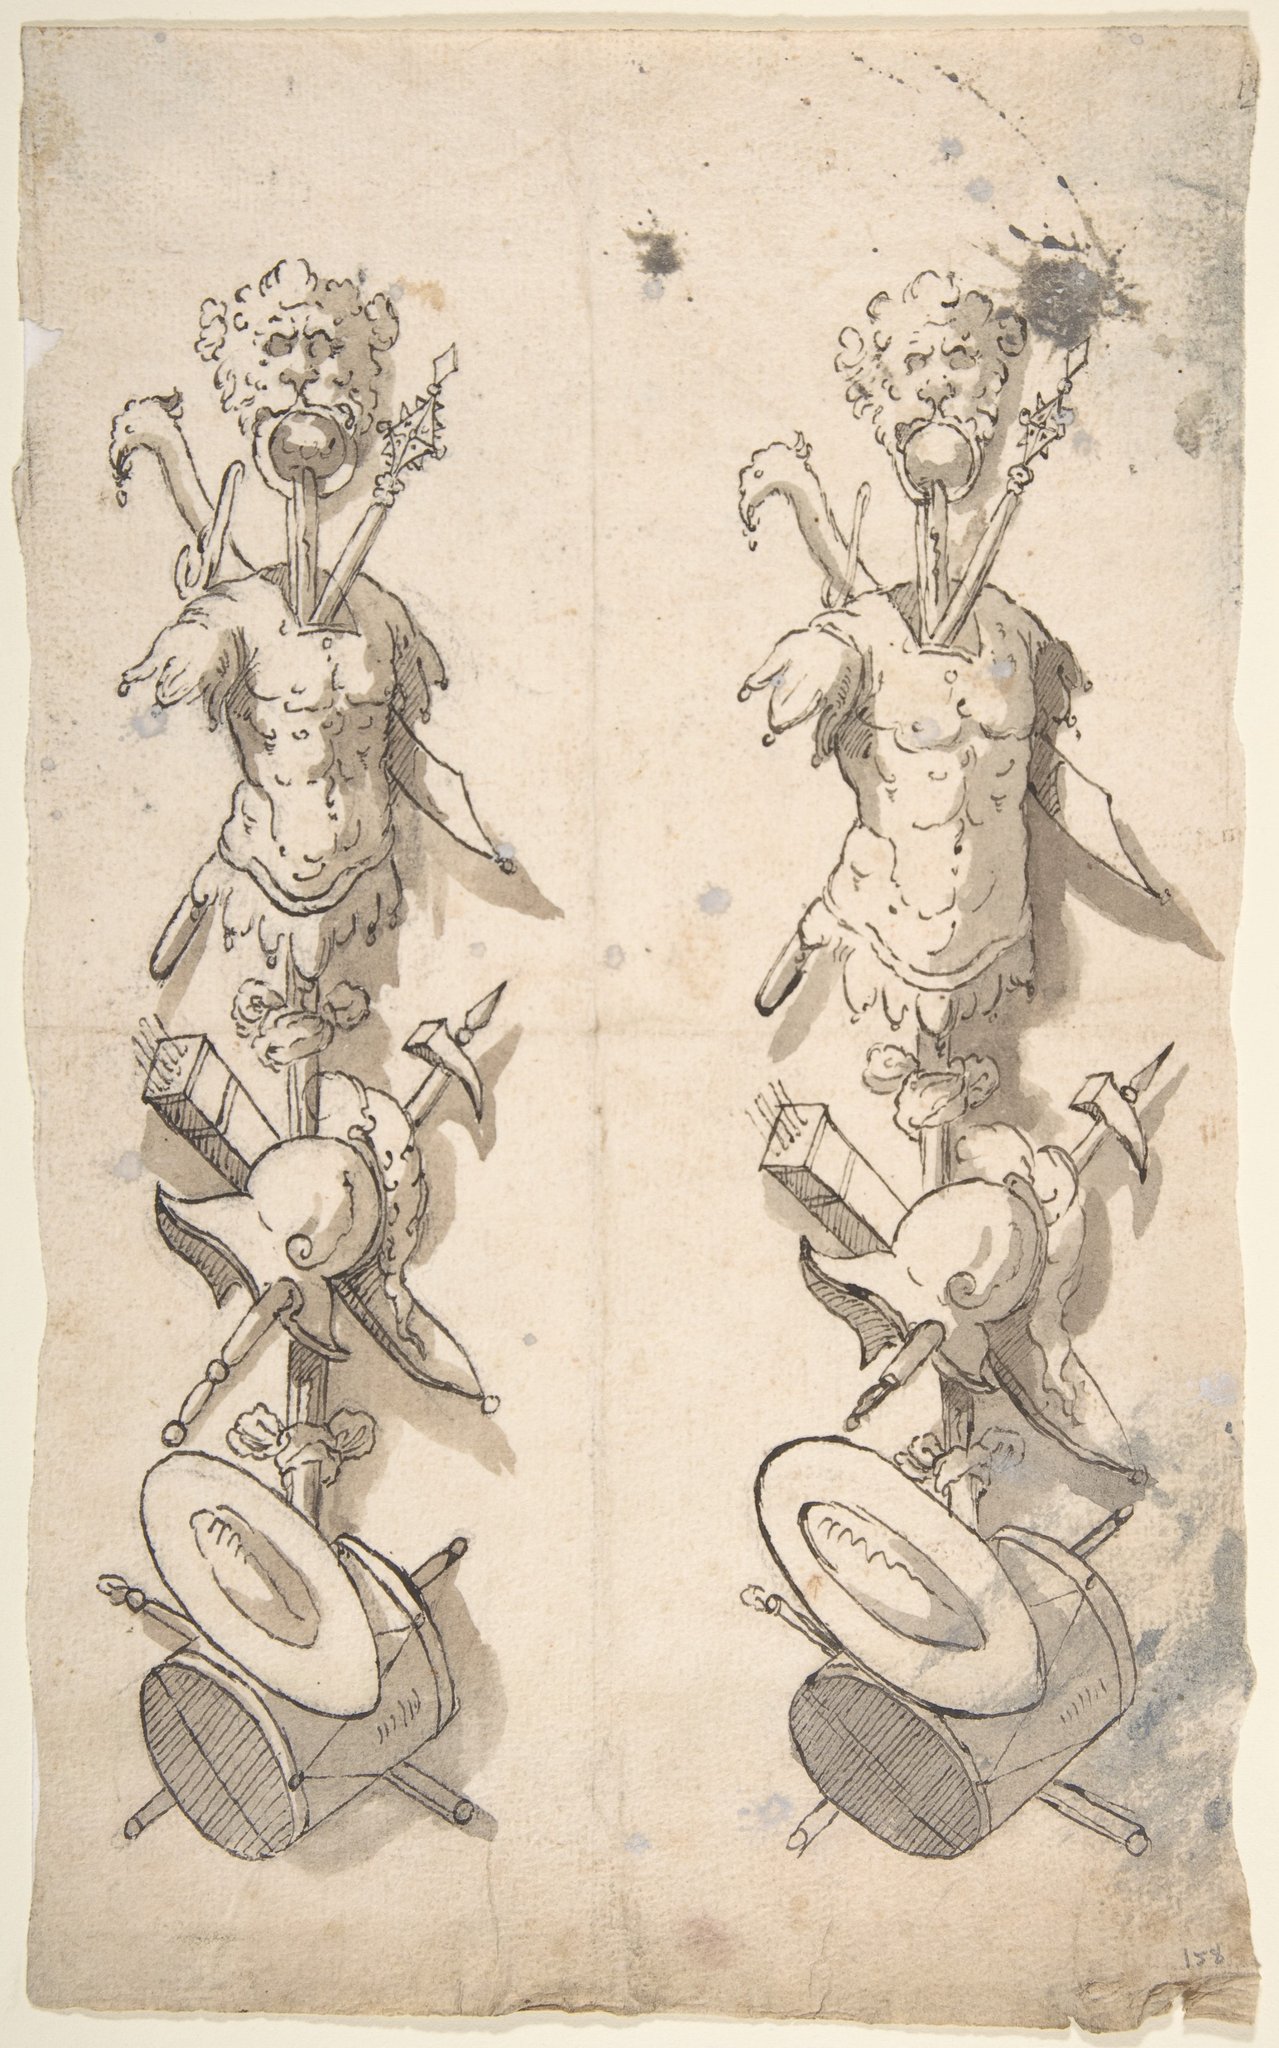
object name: drawing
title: Two Designs for Trophies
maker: anonymous, italian, piedmontese, 18th century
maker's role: artist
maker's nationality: italian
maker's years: 1700-1800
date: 1700-1780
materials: graphite, ink, drawing material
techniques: brush, pen, wash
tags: musical instruments,weapons,trophies